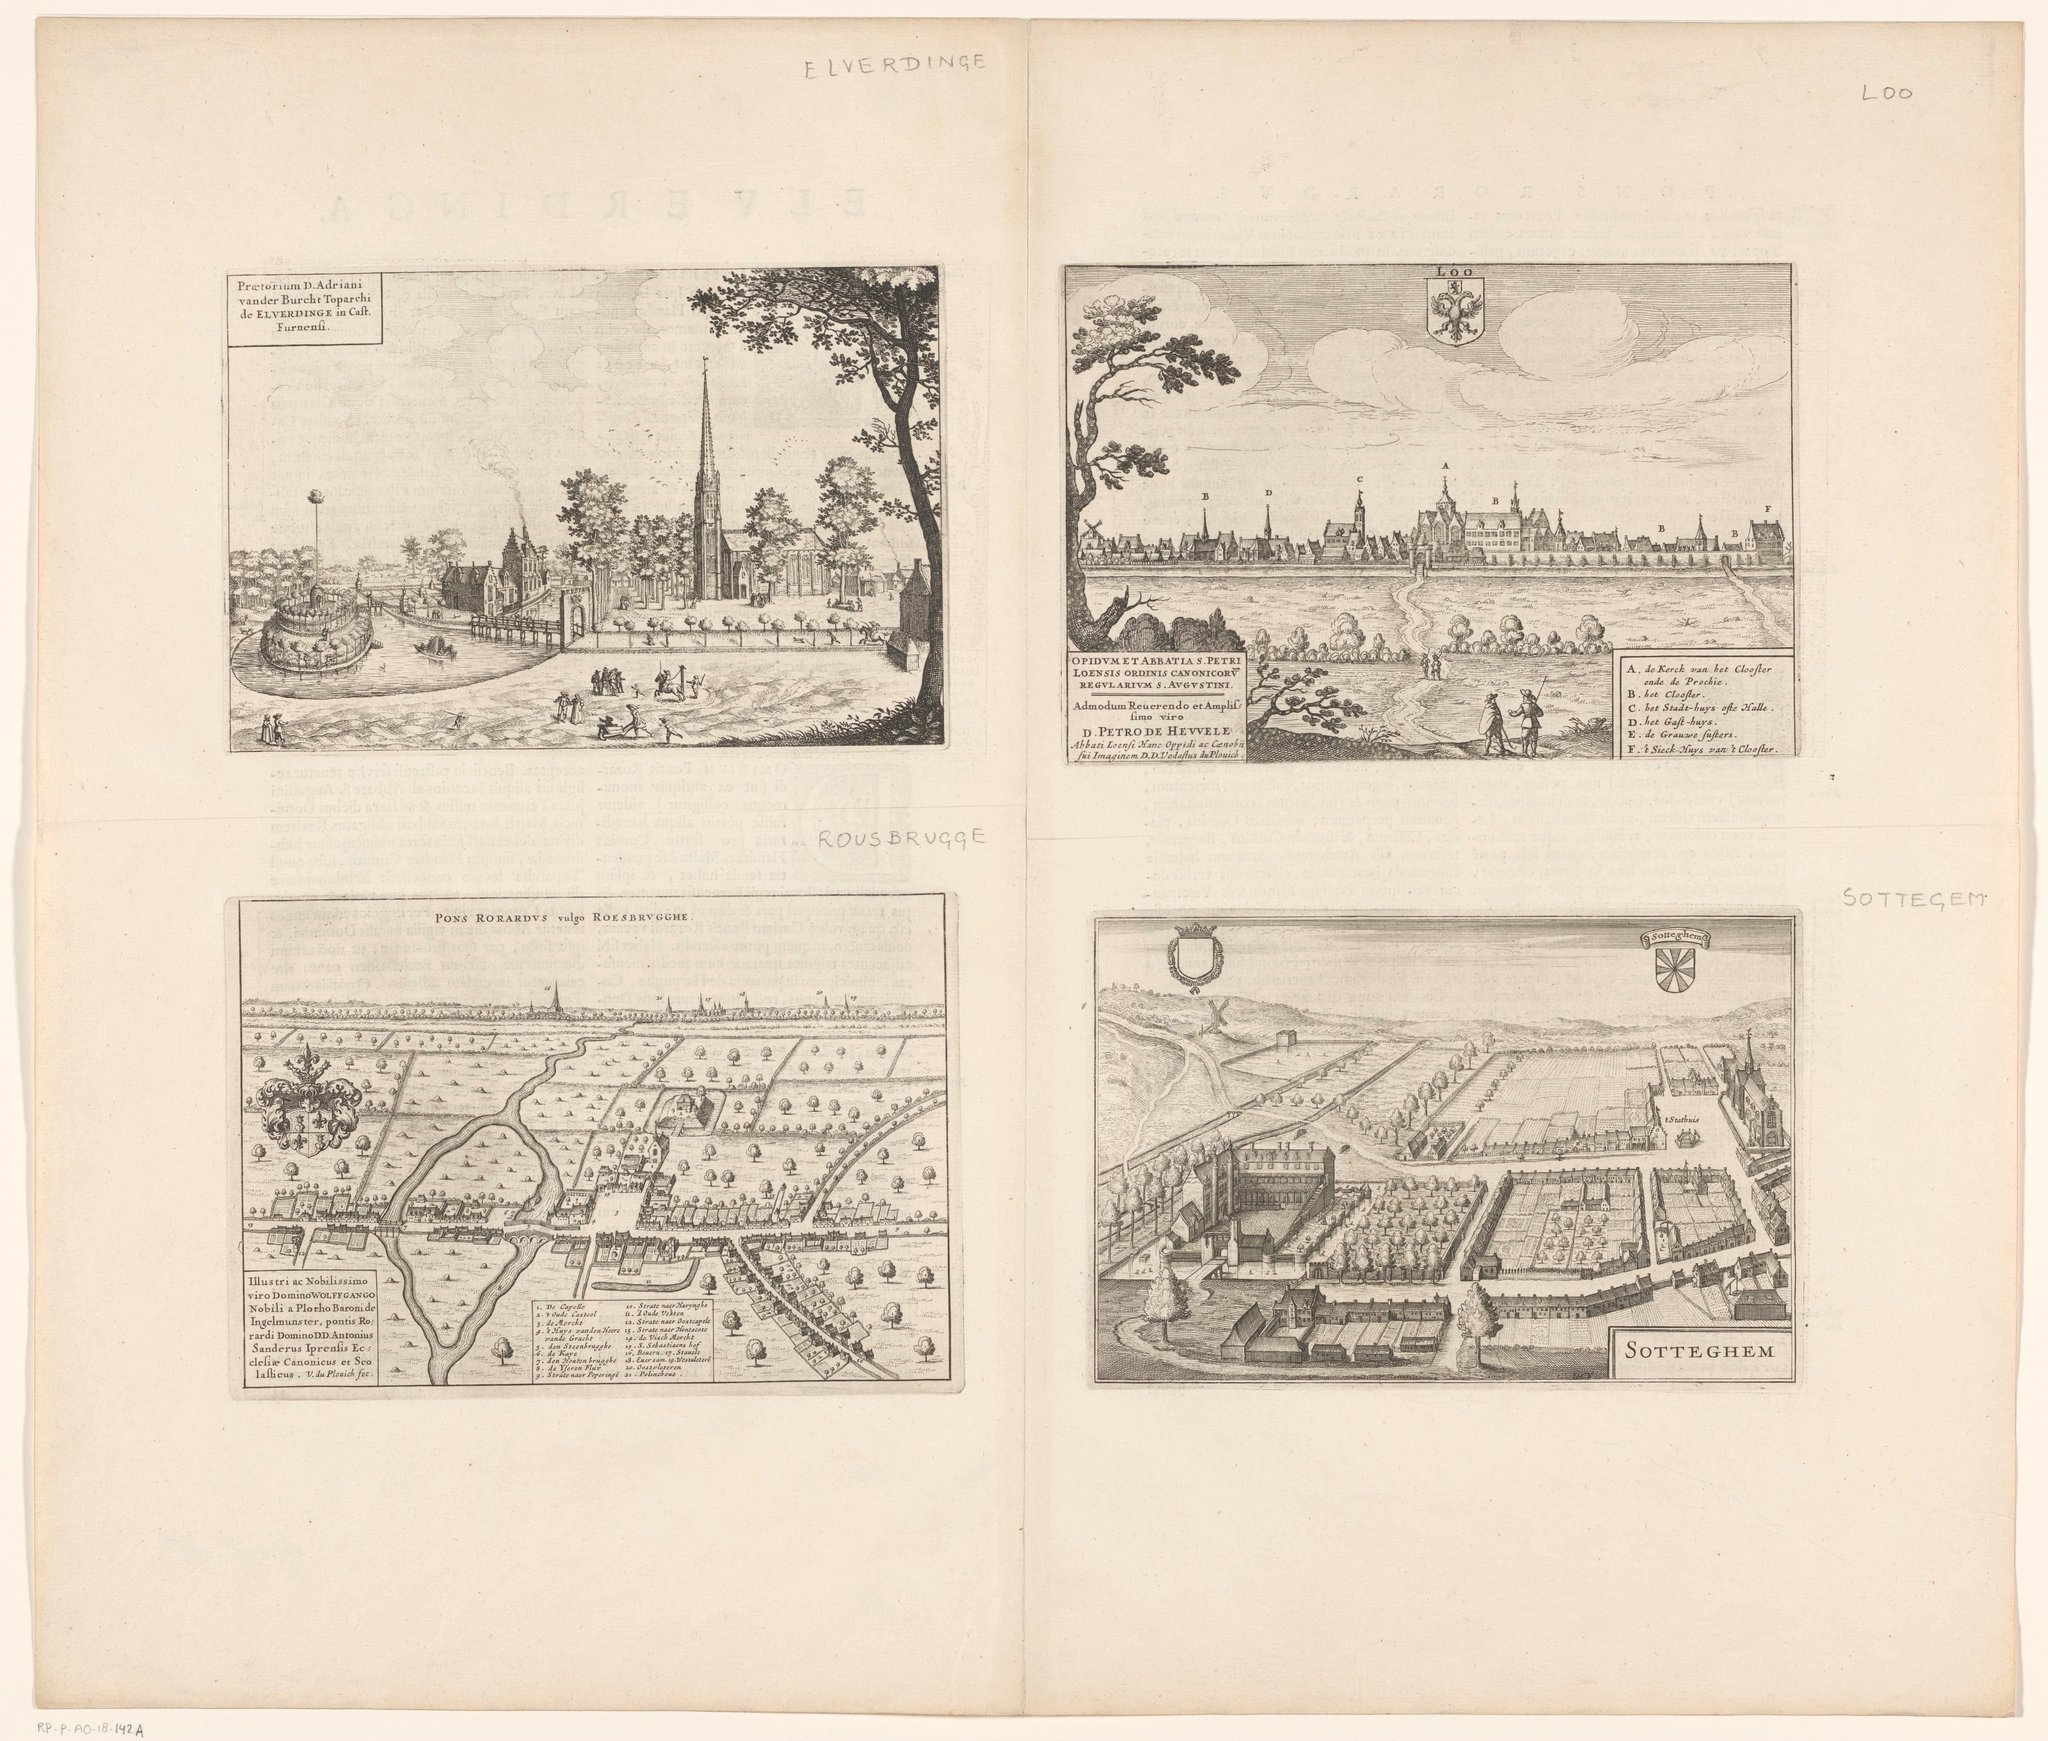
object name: print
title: Praetorium D. Adriani van der Burcht (...) / Loo / Sotteghem / Pons Roradus vulgo Roesbrugghe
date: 1652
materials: paper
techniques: engraving, etching, letterpress printing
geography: amsterdam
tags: prospect of village, silhouette of village, coat of arms (as symbol of the state, etc.) (+ city; municipal), geodesy, surveying, castle, coat of arms (as symbol of the state, etc.) (+ province; provincial)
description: Linksboven een gezicht op de kerk en het huis van Adriaan van der Burcht in Elverdinge. Rechtsboven een gezicht op Lo, met rechtsonder een legenda A-F. Boven, in het midden, een wapen met de dubbelkoppige adelaar van het heilig Roomse Rijk en bovenin de leeuw van Vlaanderen. Rechtsonder een gezicht in vogelvluchtperspectief op Zottegem, met rechtsonder een kader met de titel. Linksboven een leeg wapenschild met daaromheen de keten van de Orde van het Gulden Vlies. Rechtsboven het wapen van Zottegem. Linksonder een plattegrond in vogelvluchtperspectief van Roesbrugge. Onder, in het midden, een legenda 1-21. Met Latijnse tekst op verso.